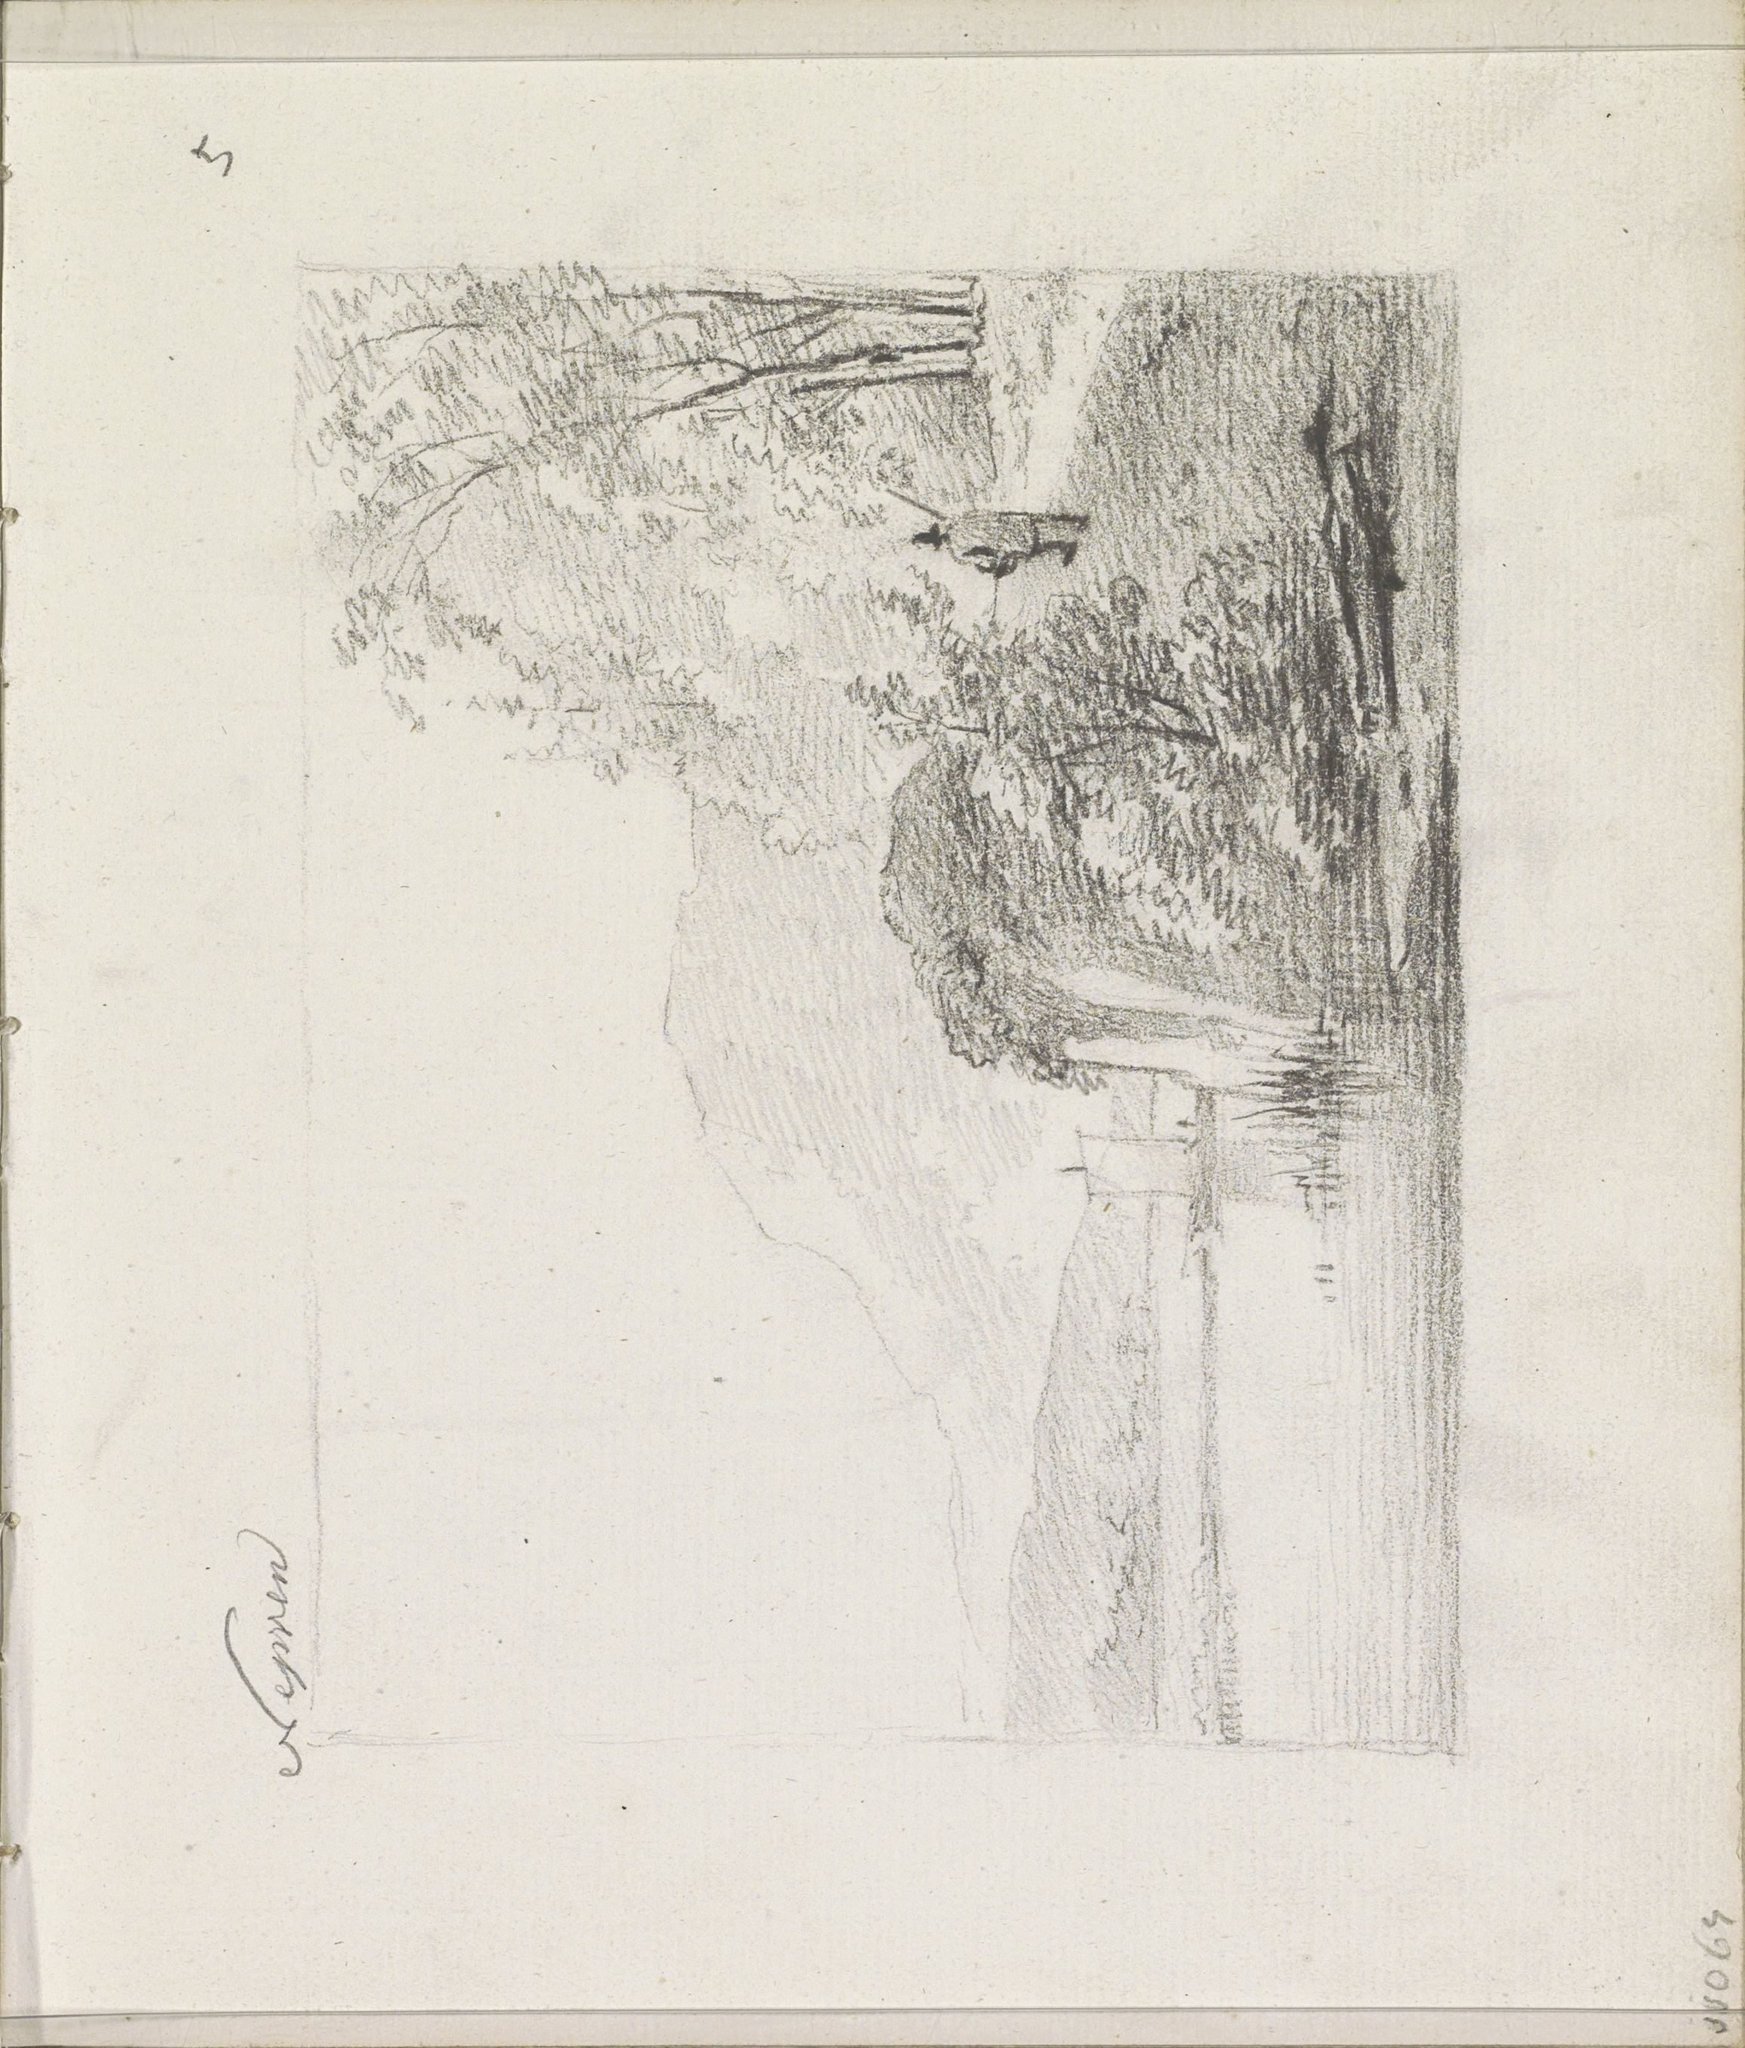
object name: sketchbook leaf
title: Berglandschap met een wandelaar langs een rivier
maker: andreas schelfhout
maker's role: draughtsman, painter, print maker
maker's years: 1787-1870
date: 1825-1829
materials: chalk, paper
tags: landscapes with waters, waterscapes, seascapes (in the temperate zone), mountains (+ landscape with figures, staffage)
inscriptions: annotation: ‘Ne[...]ven’, number: ‘5/ 33064’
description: Blad 19 recto uit een schetsboek met 95 bladen.